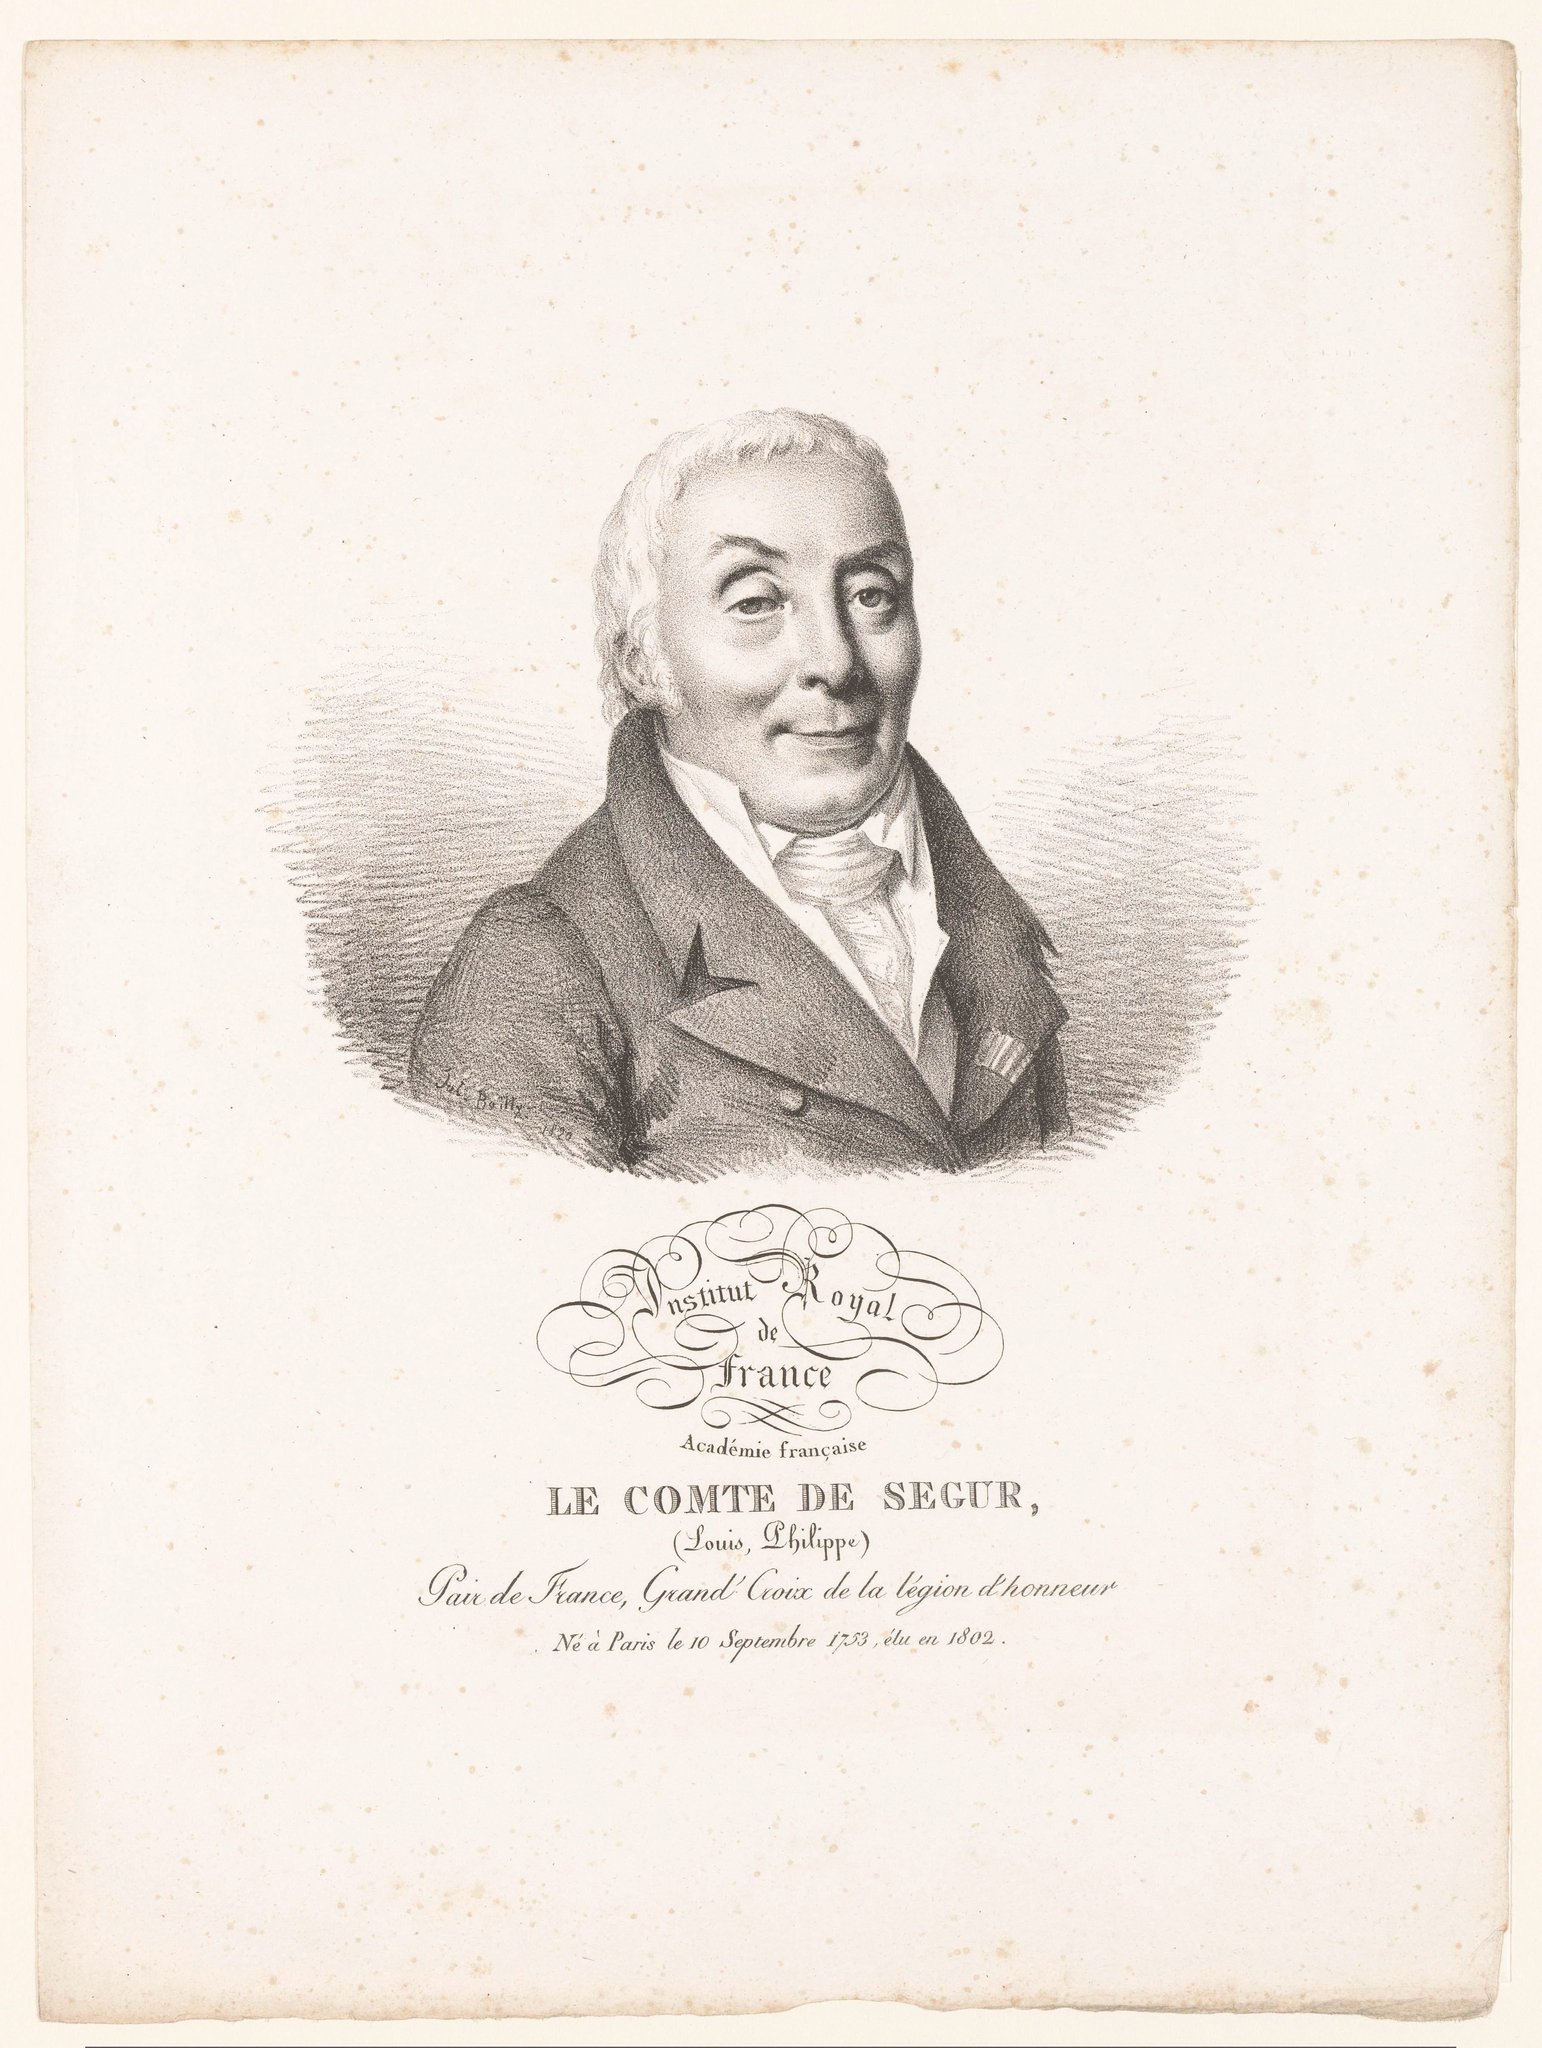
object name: print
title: Leden van het Institut Royal de France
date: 1820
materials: paper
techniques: lithograph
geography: paris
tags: paris, politician, historical persons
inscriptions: collector's mark: Lugt 2228a